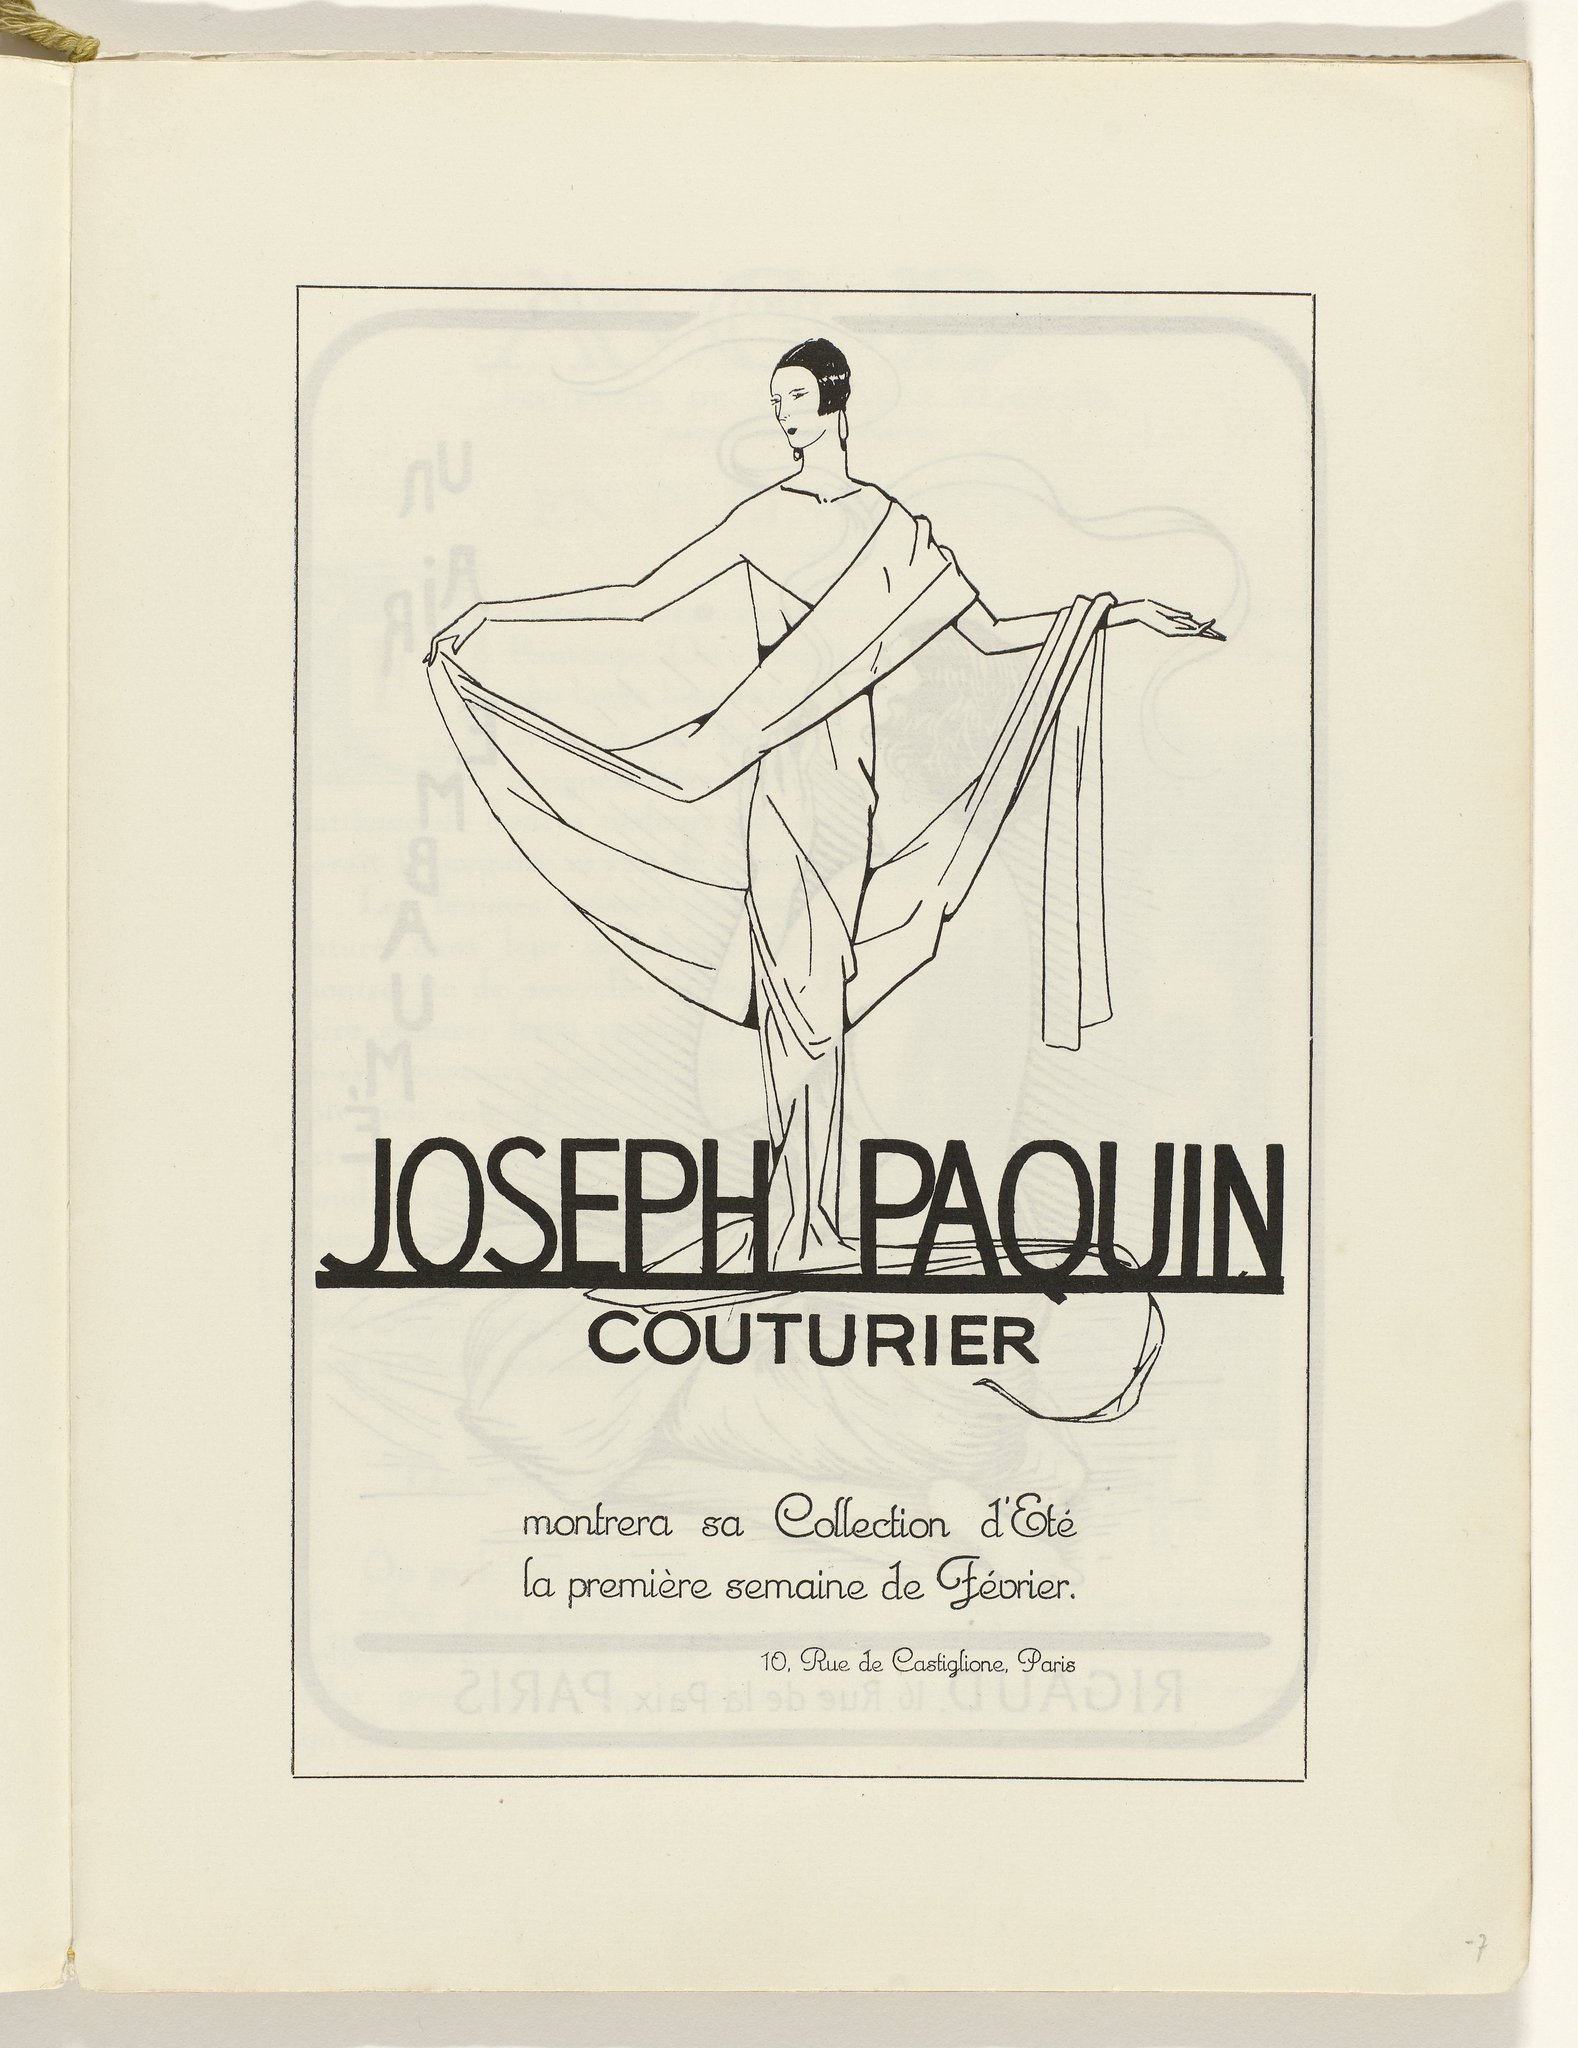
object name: magazine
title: Art - Goût - Beauté, Feuillets de l' élégance féminine, Février 1926, No. 66, 6e Année, p. 7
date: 1926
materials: paper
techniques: lithograph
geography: paris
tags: drapery, draped garment, 'gewandgebung' (+ women's clothes), fashion plates, dress, gown (+ women's clothes)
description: Advertentie voor de zomercollectie van Joseph Paquin. Pagina uit het modetijdschrift Art-Goût-Beauté (1920-1933).